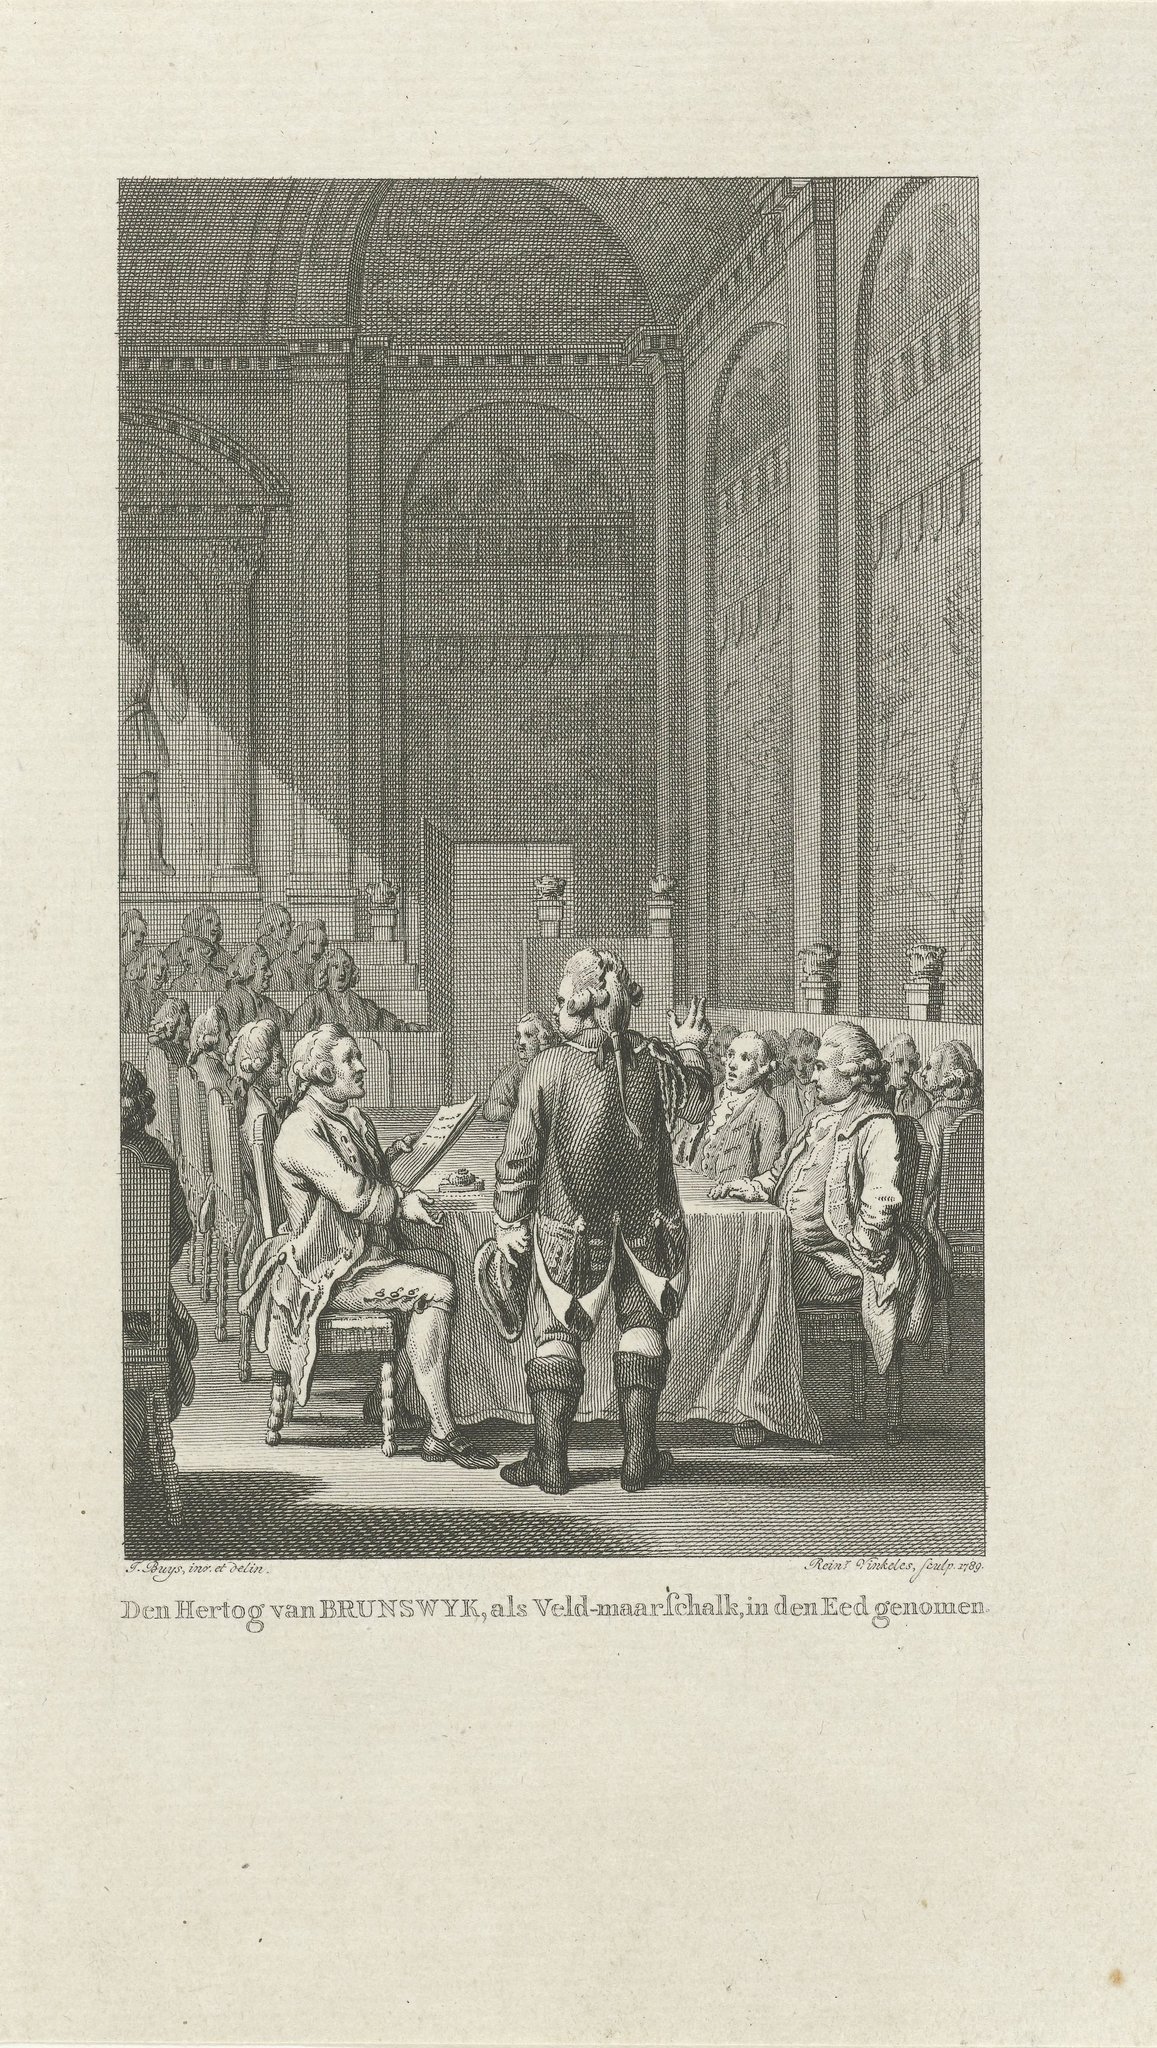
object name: history print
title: Den Hertog van Brunswyk, als Veld-maarschalk, in den Eed genomen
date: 1789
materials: paper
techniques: engraving, etching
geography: northern netherlands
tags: the hague, william v (prince of orange), ludwig ernst von braunschweig-wolfenbüttel, new ruler taking the oath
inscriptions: collector's mark: Lugt 2228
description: Gebruikt als illustratie in: P.A. Loosjes. Vaderlandsche historie, vervattende de geschiedenissen, der Vereenigde Nederlanden (...). Drie-en-twintigste deel. Beginnende met den jaare 1759 en eindigende met den jaare 1765, bevattende het tydperk der minderjaarigheid des erfstadhouders Willem den V. Ten onmiddelyken vervolge van Wagenaar's Vaderlandsche historie. Amsterdam: J. Allart, 1797.